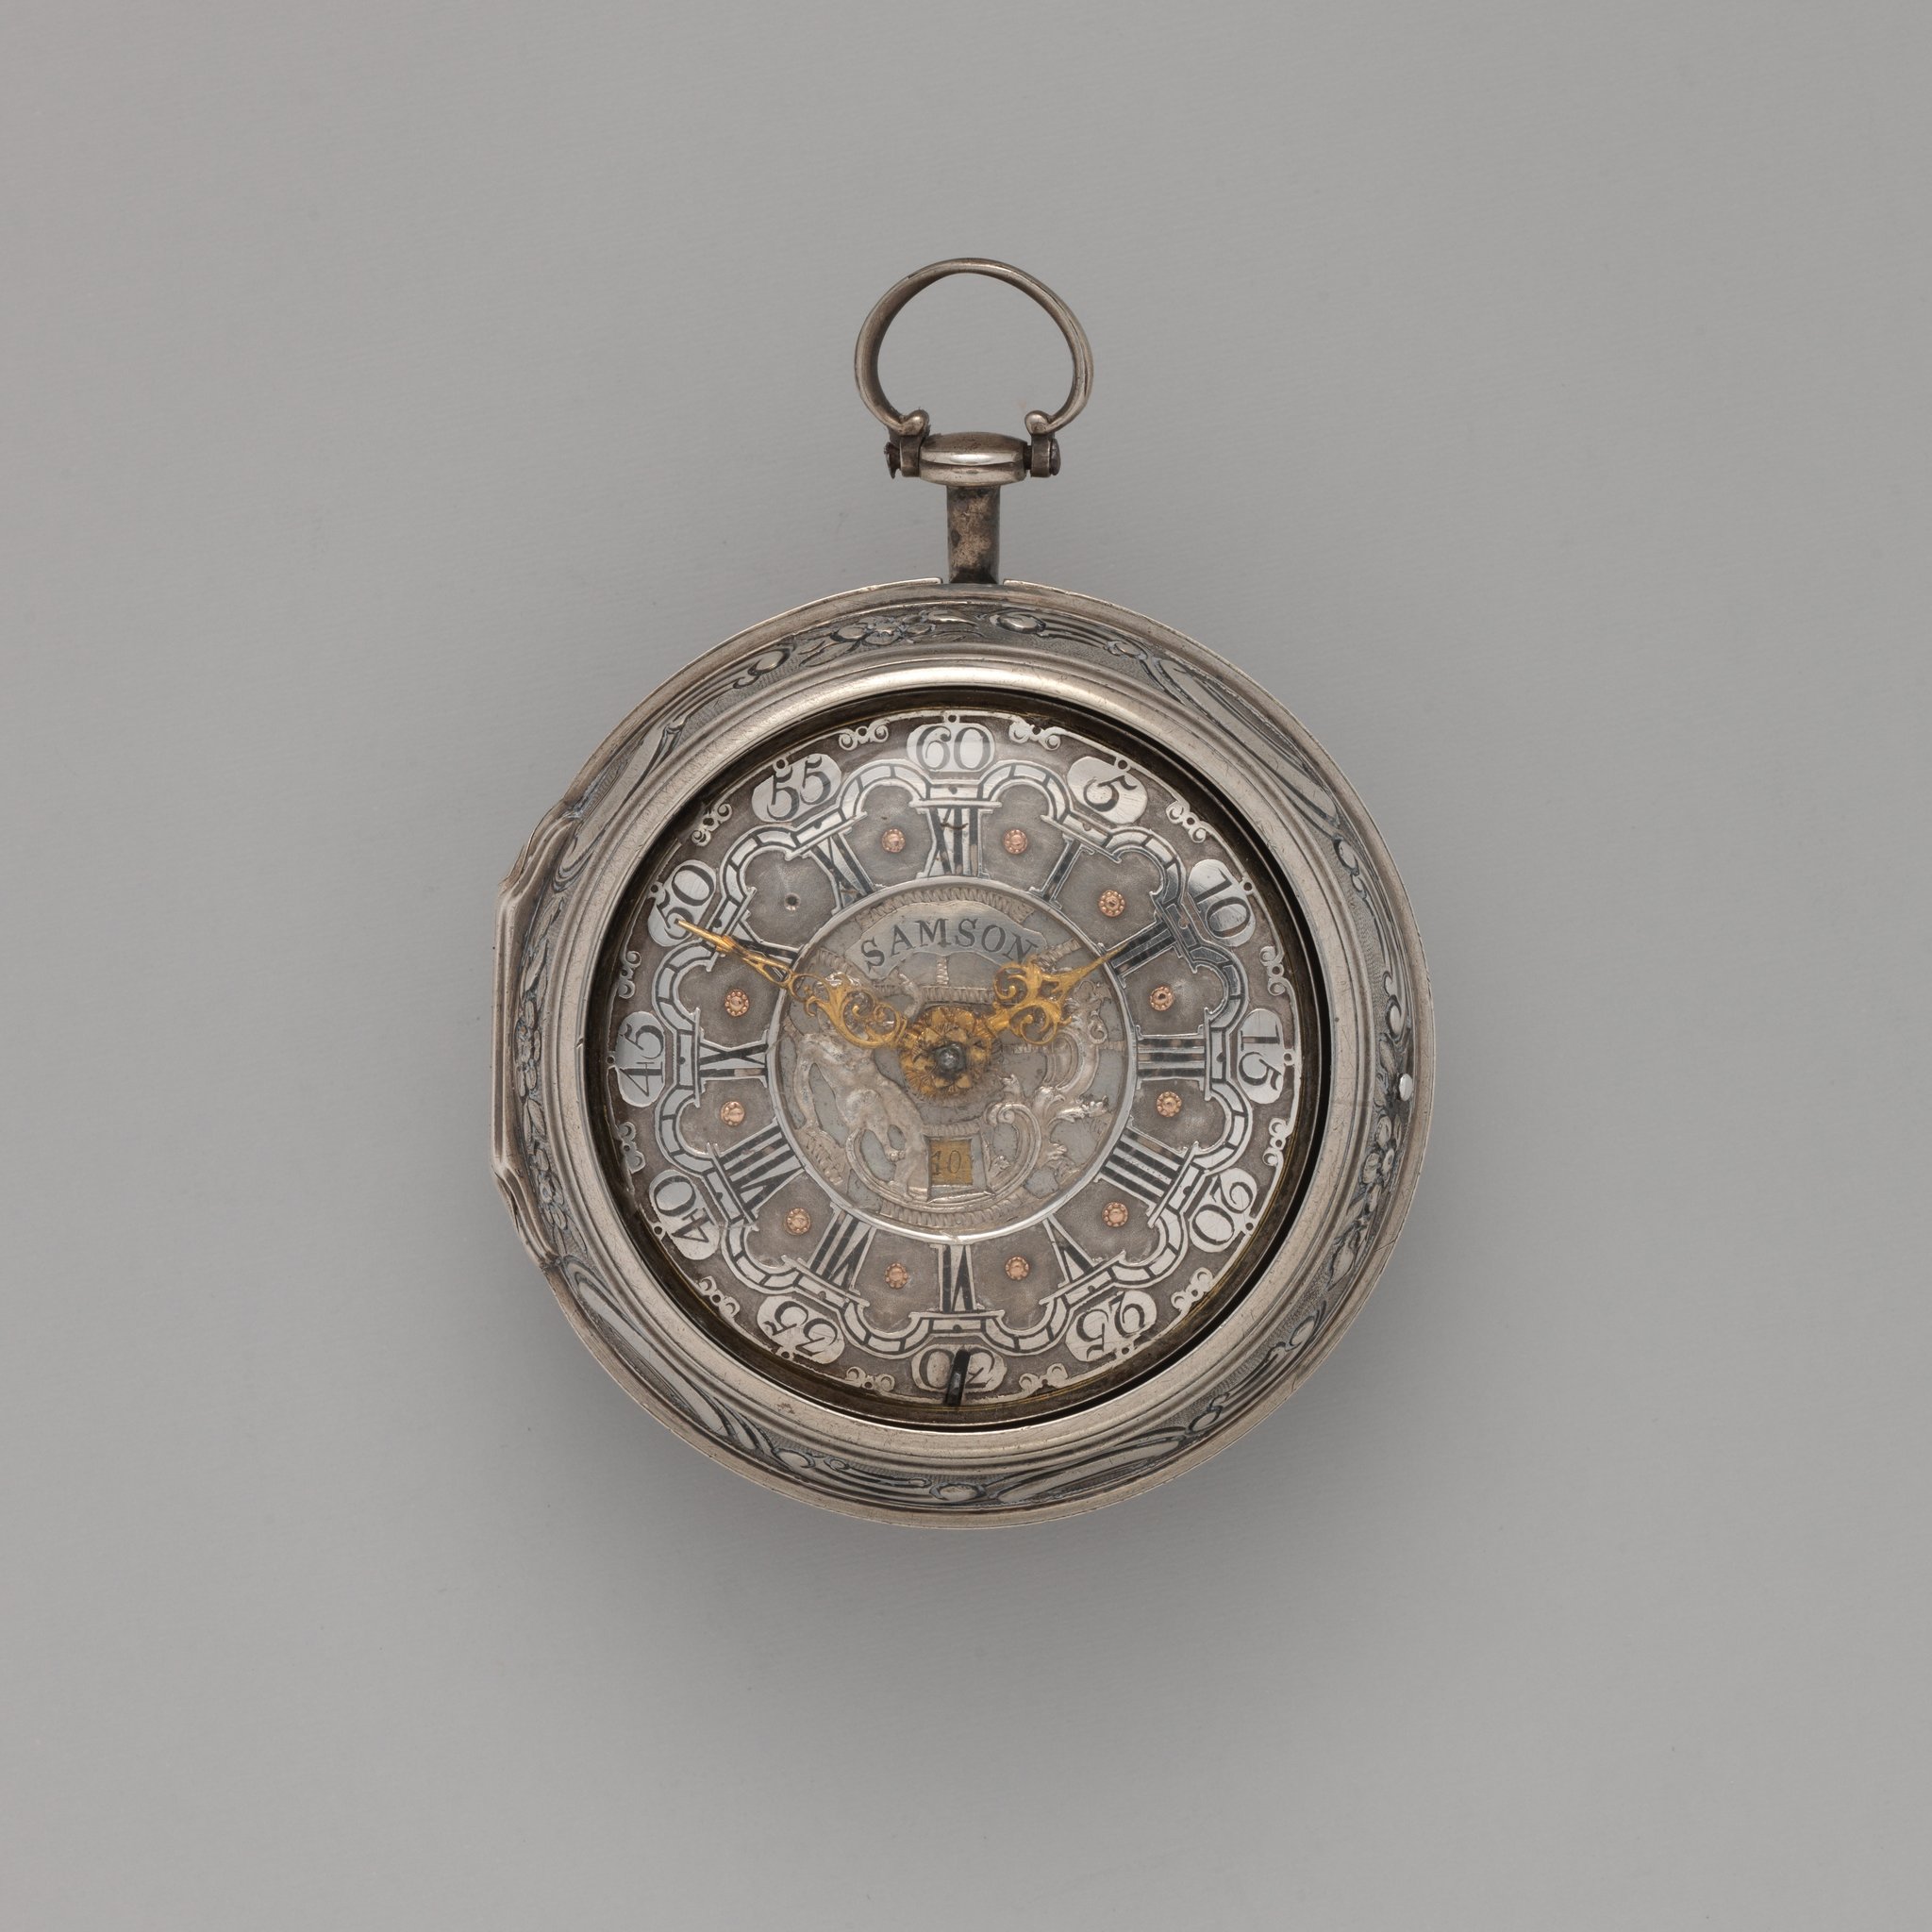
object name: watch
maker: j. samson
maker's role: maker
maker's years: 1760-1796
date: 1759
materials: silver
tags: men,women